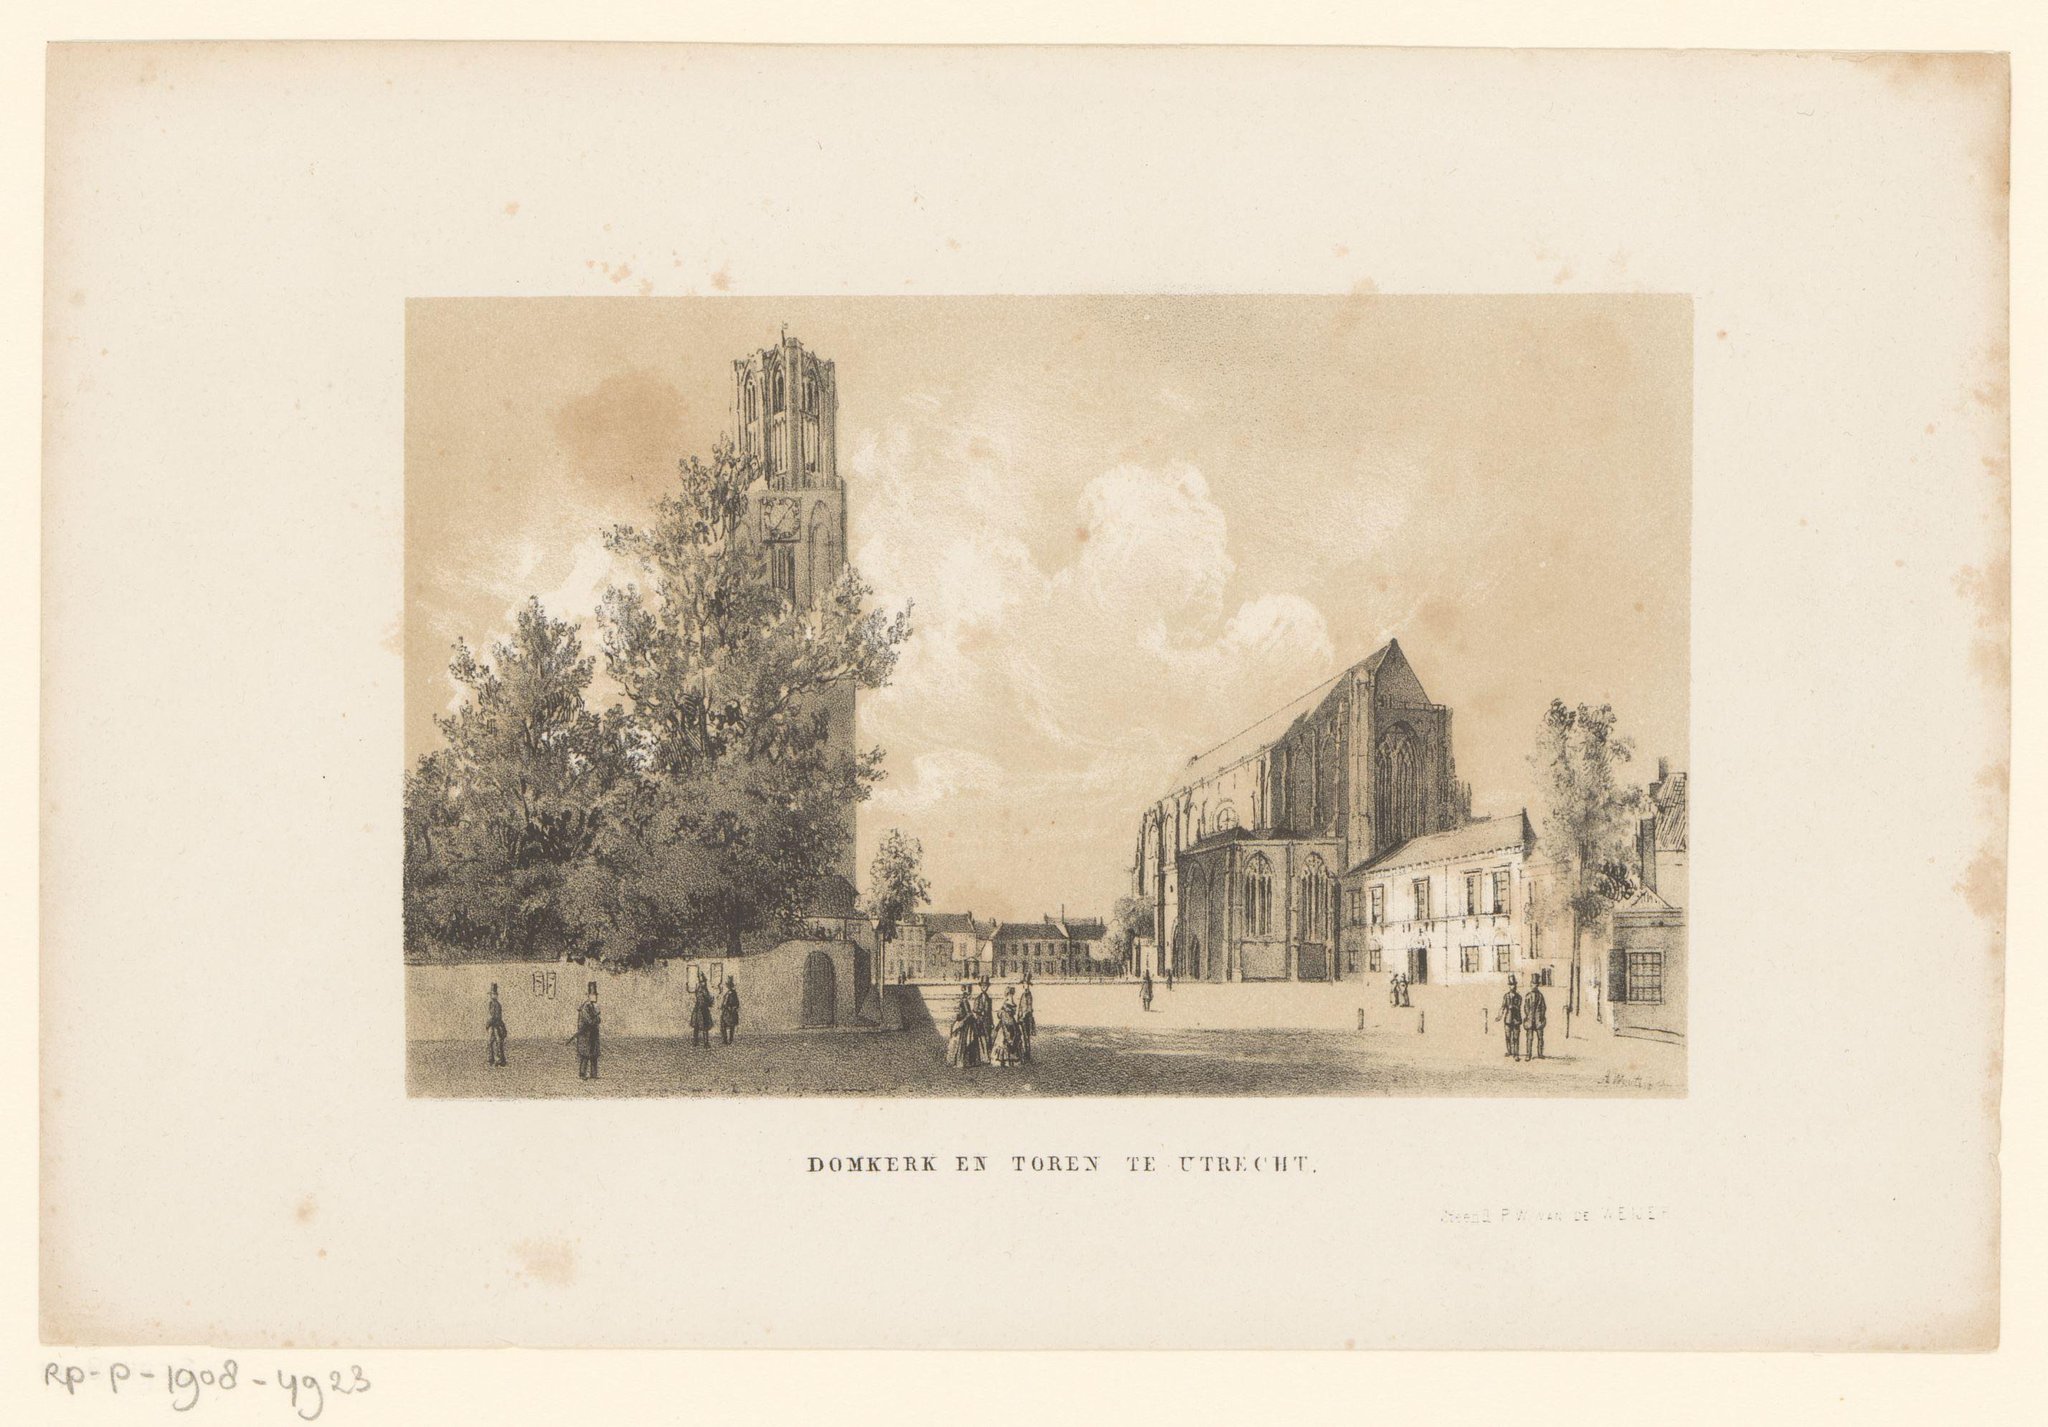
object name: print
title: Gezicht op de Domtoren en kerk in Utrecht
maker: pieter wilhelmus van de weijer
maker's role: print maker, printer, publisher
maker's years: 1816-1880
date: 1856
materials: paper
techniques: tone lithography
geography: utrecht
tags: city-view, and landscape with man-made constructions, parts of church exterior and annexes: tower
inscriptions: collector's mark: Lugt 2228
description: Mogelijk maakte deze prent deel uit van: Utrecht's Album, Utrecht: W.F.Dannenfelser, 1856.